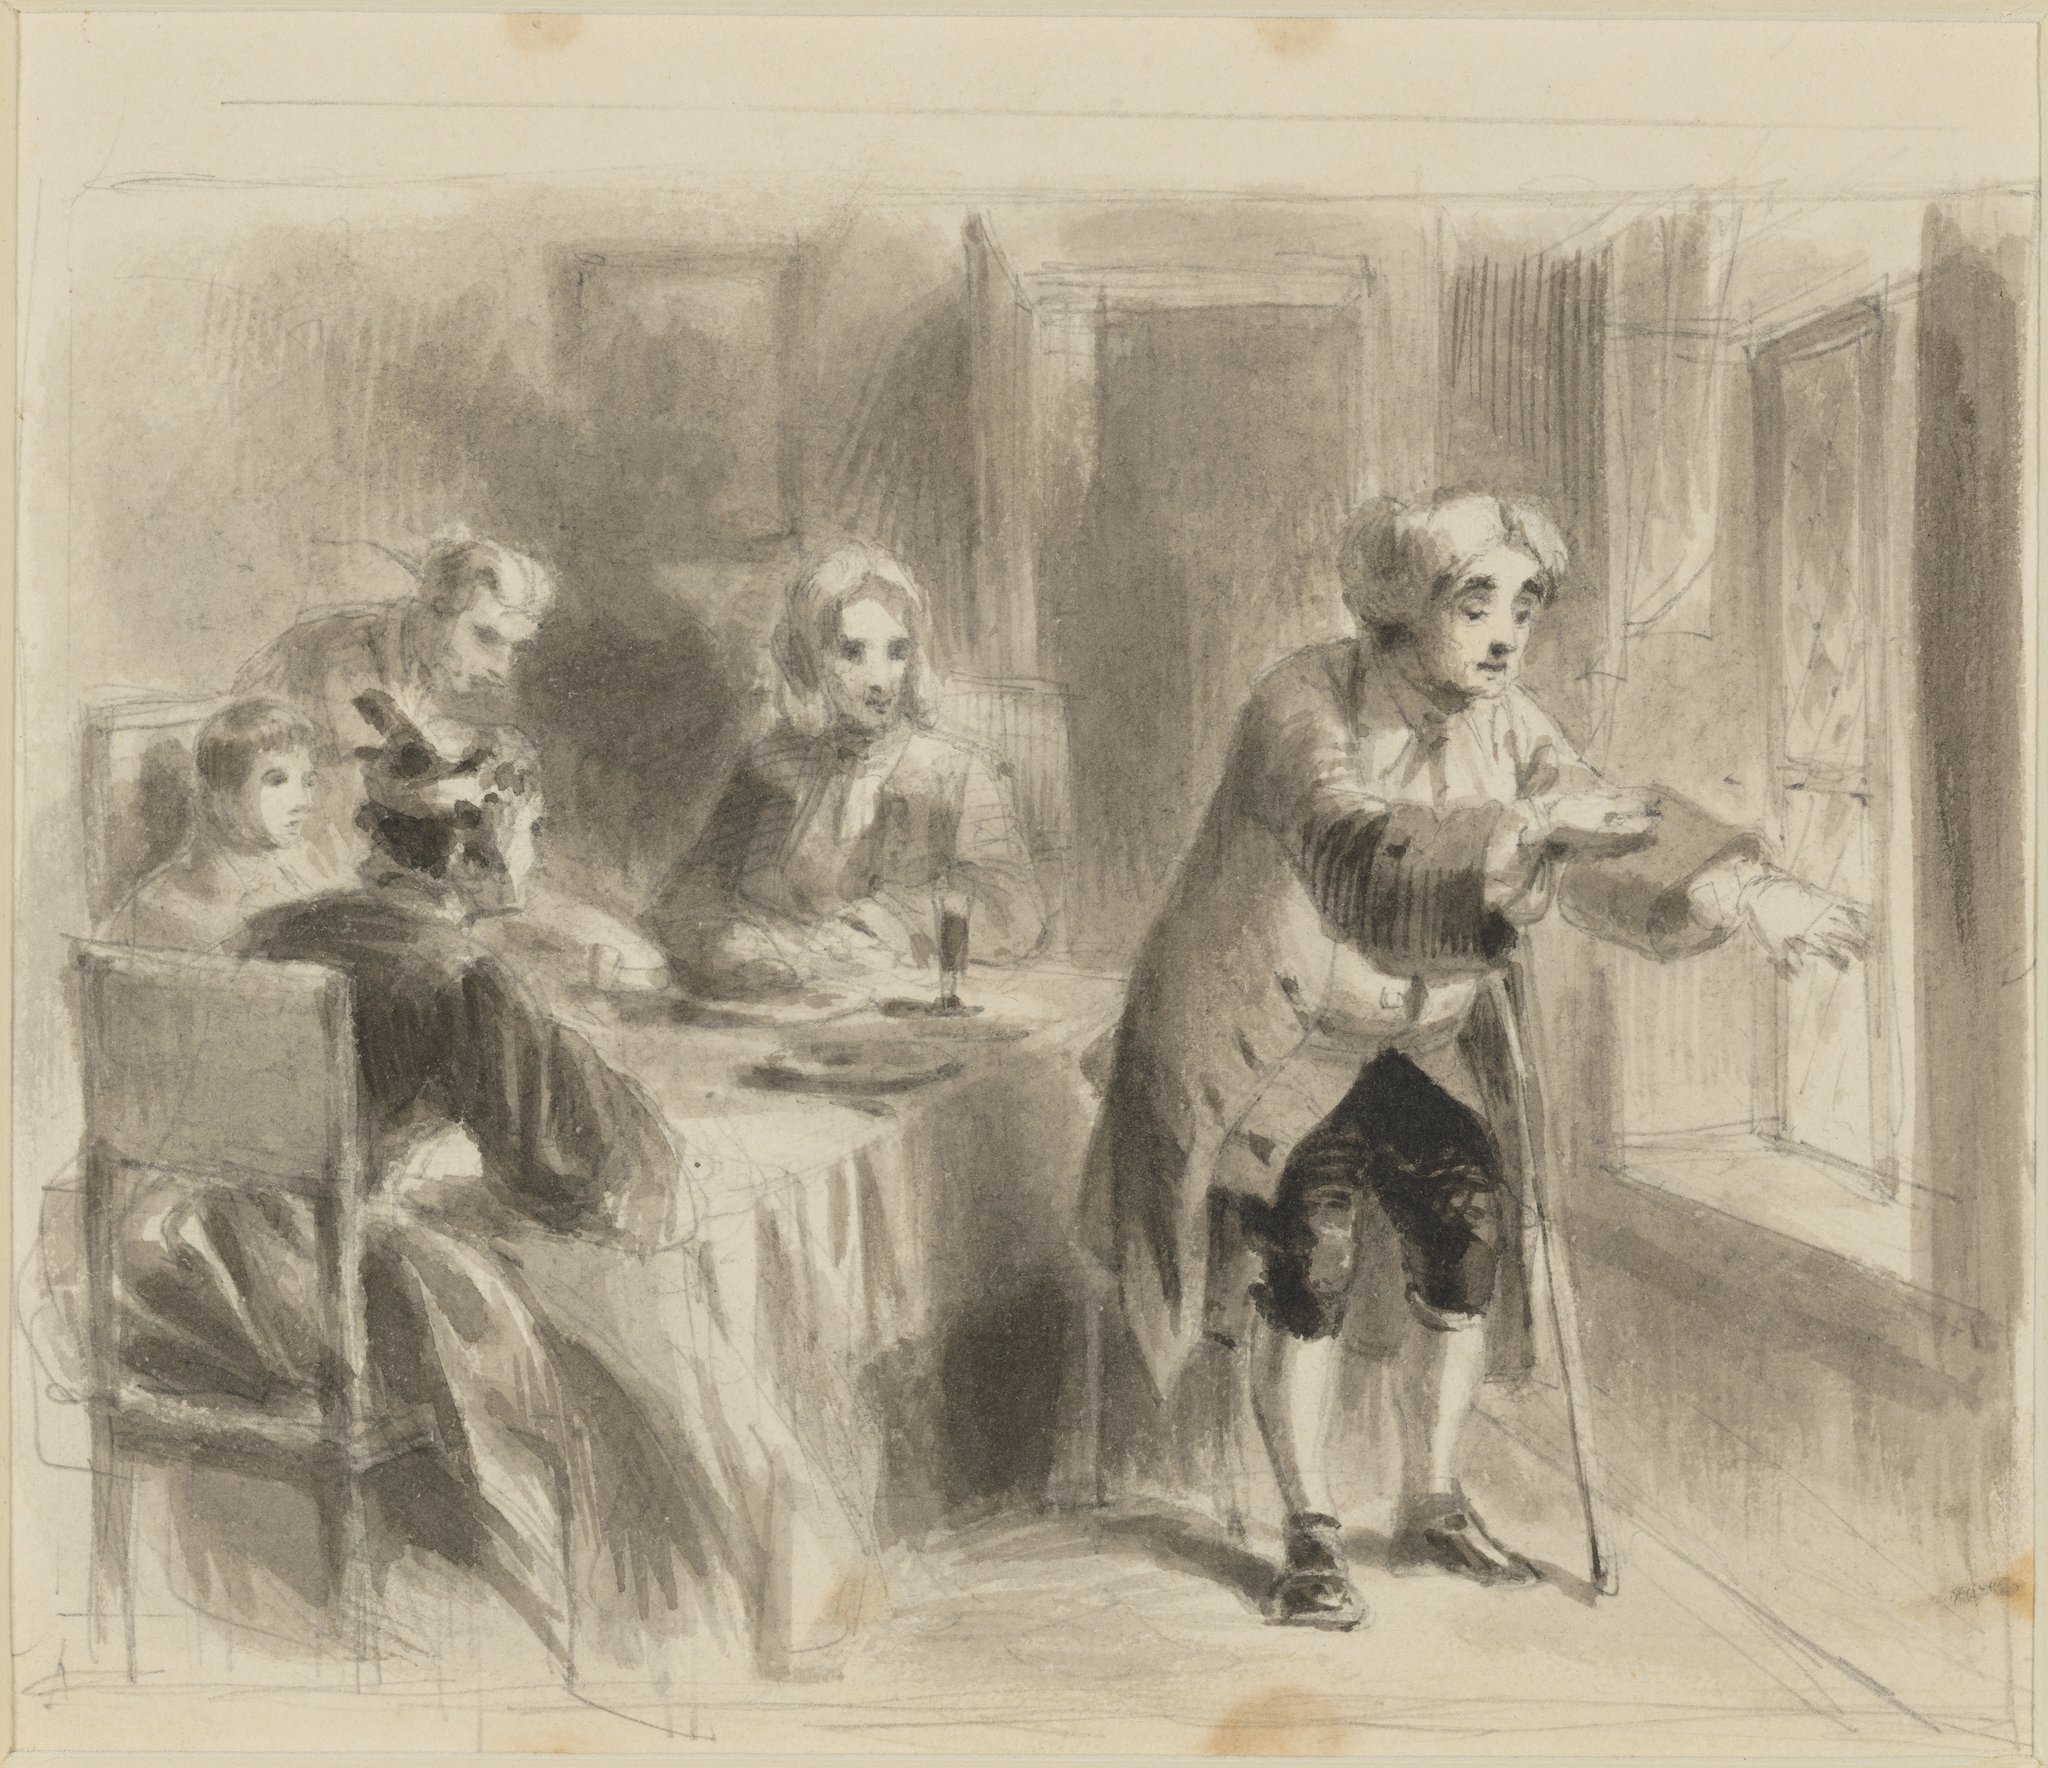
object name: drawing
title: Uncle Toby and the Fly (from Laurence Sterne's "Tristram Shandy")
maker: felix octavius carr darley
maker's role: artist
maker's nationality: american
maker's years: 1822-1888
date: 1847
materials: graphite, ink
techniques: wash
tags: men,women